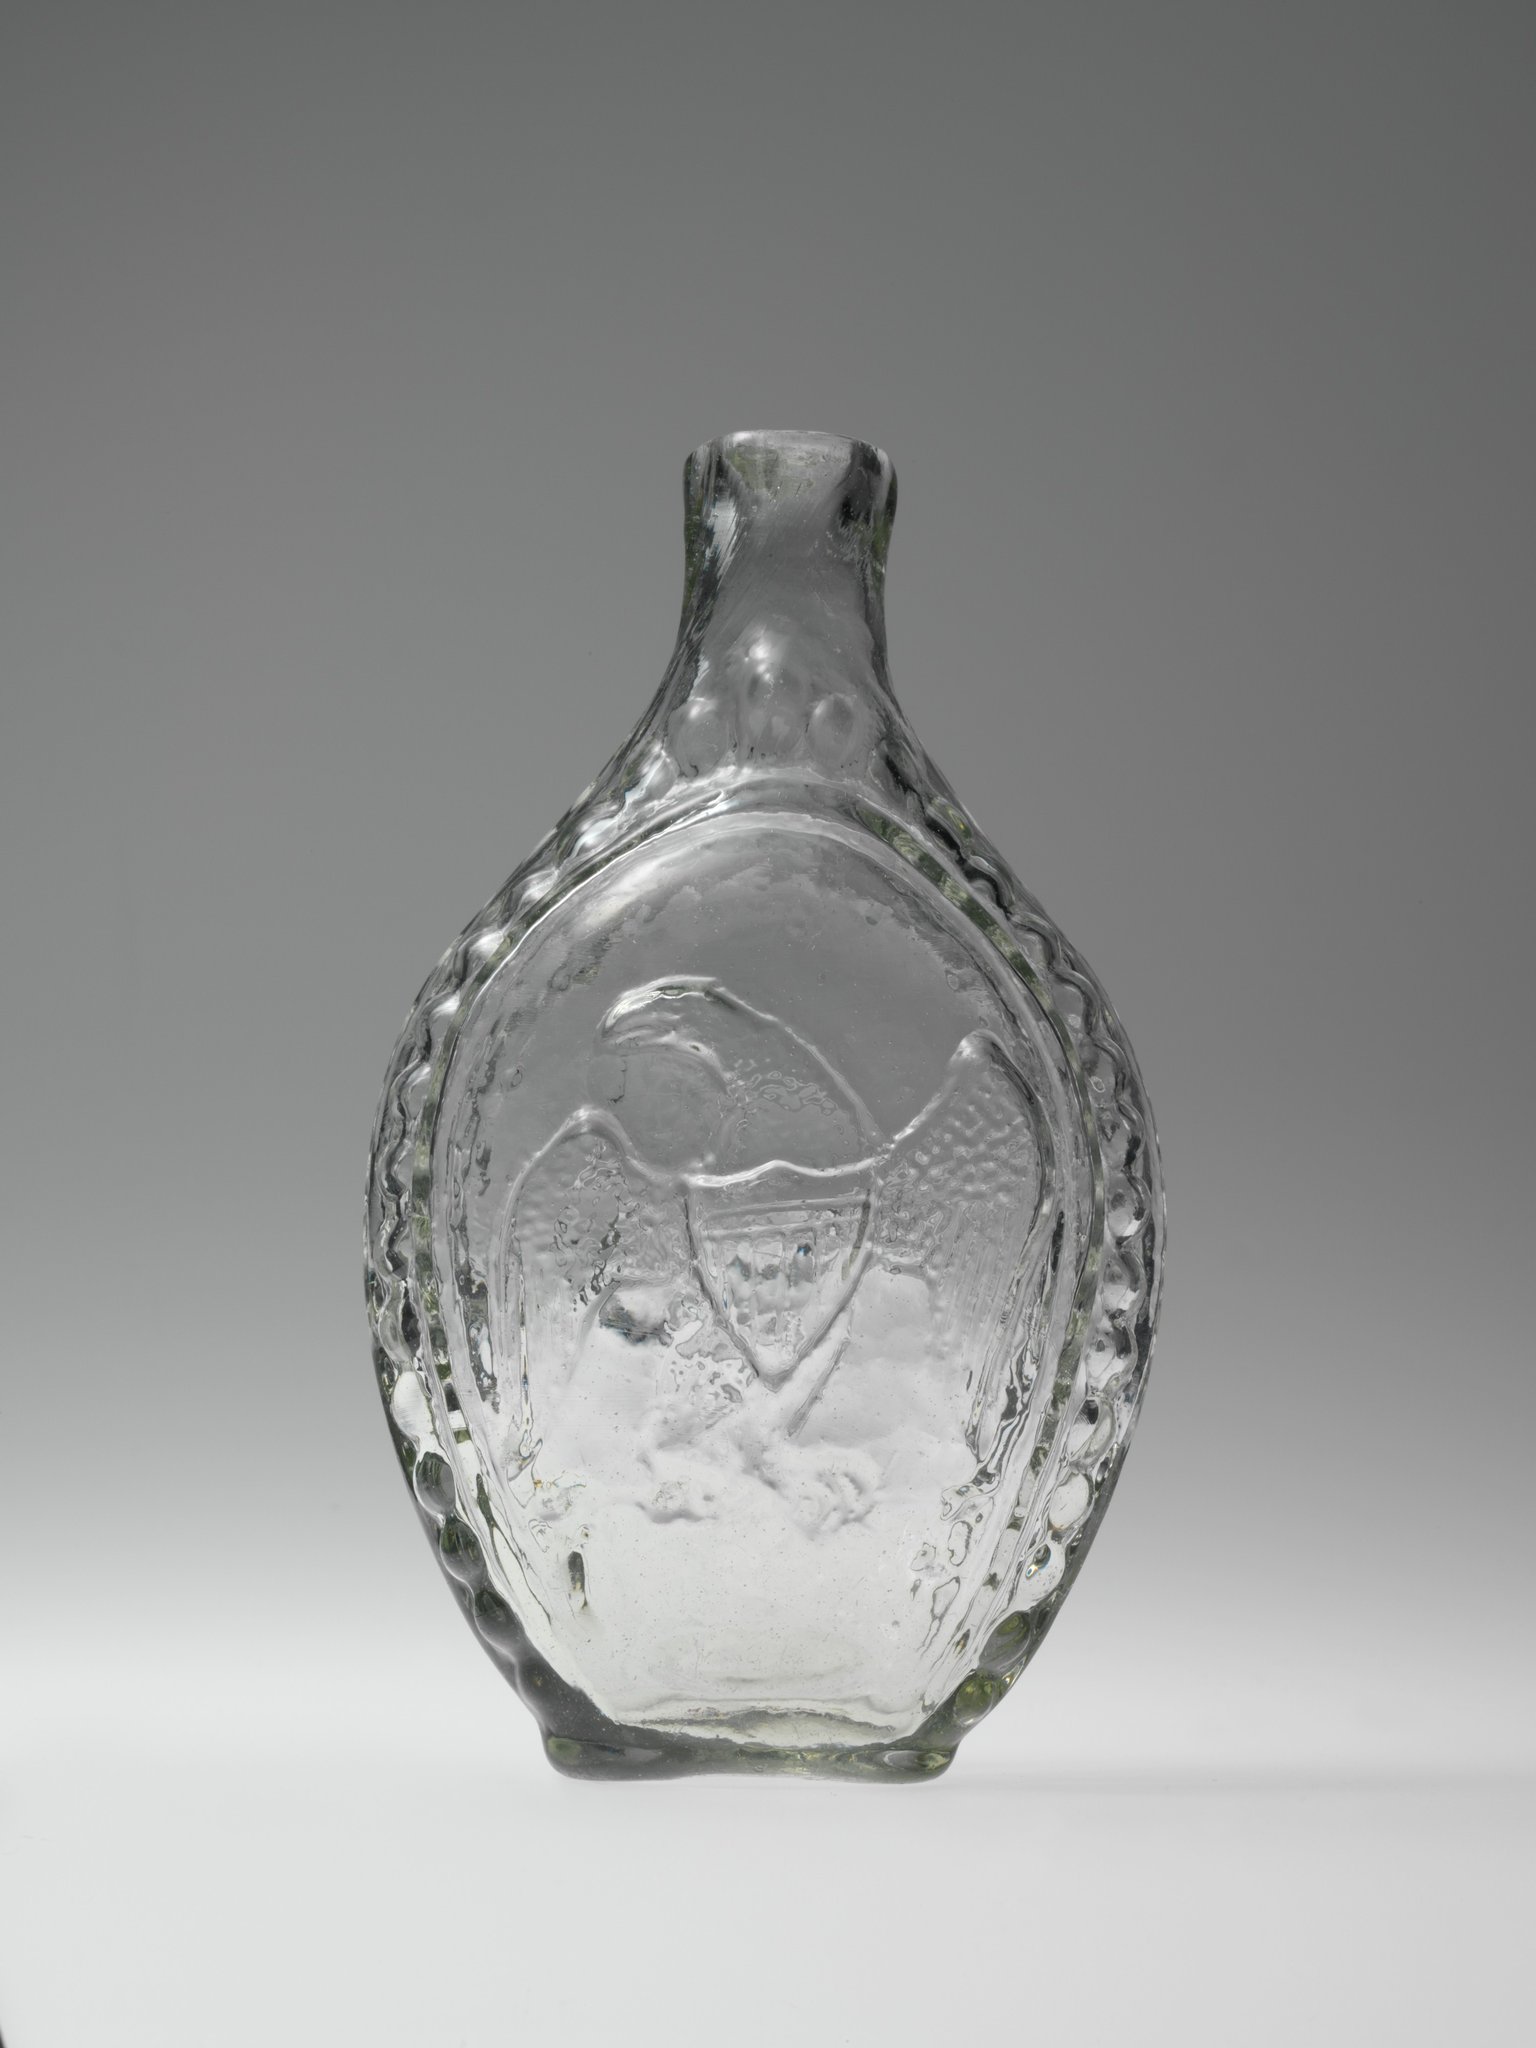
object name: flask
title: Figured flask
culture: american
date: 1836-1840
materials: glass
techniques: glassblowing, molding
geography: united states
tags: eagles